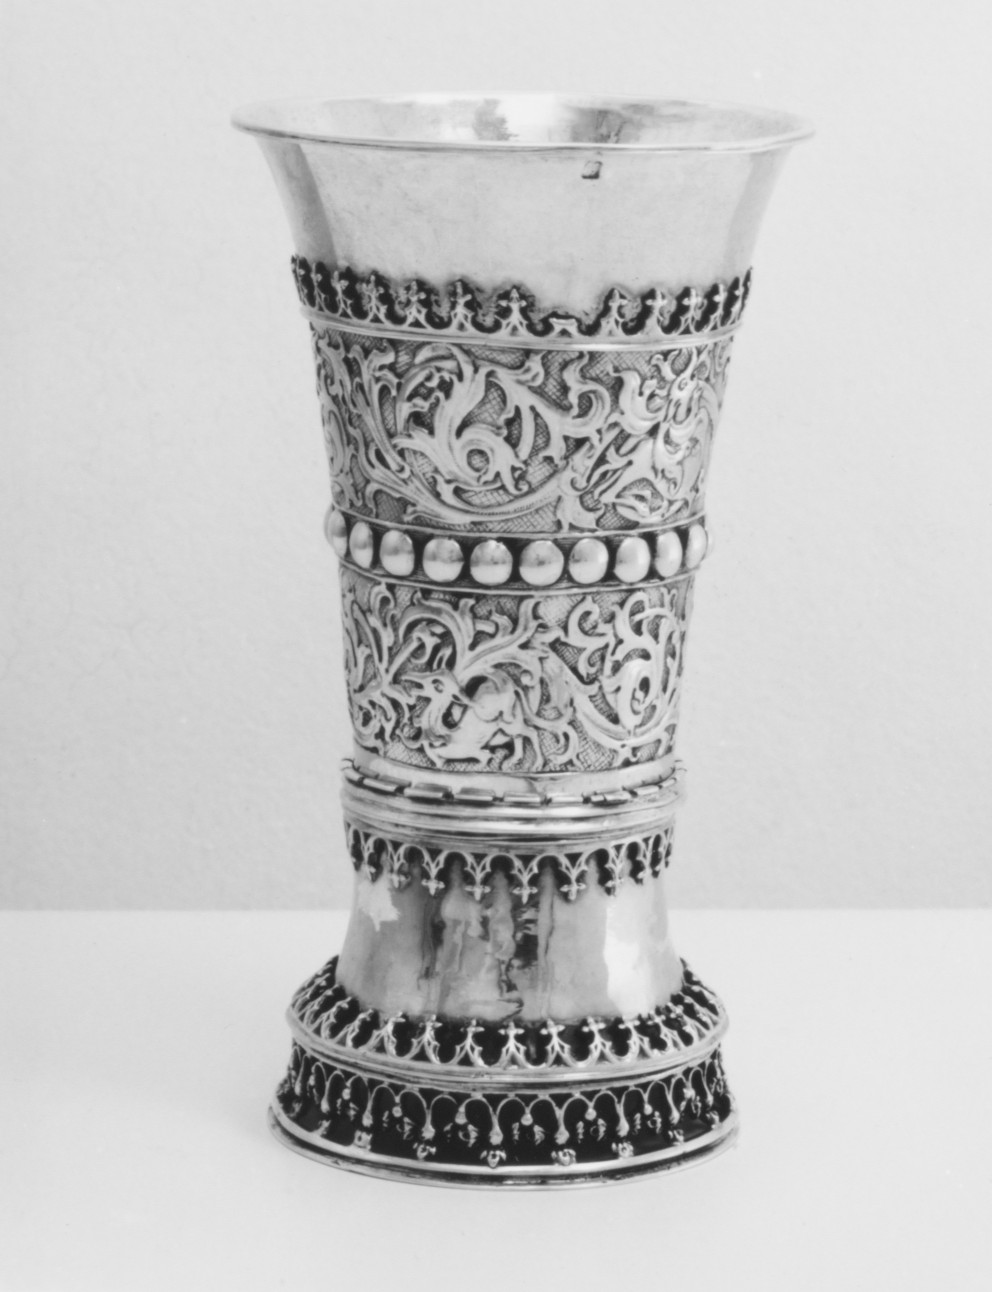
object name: beaker on stand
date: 1600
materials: silver gilt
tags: mythical creatures